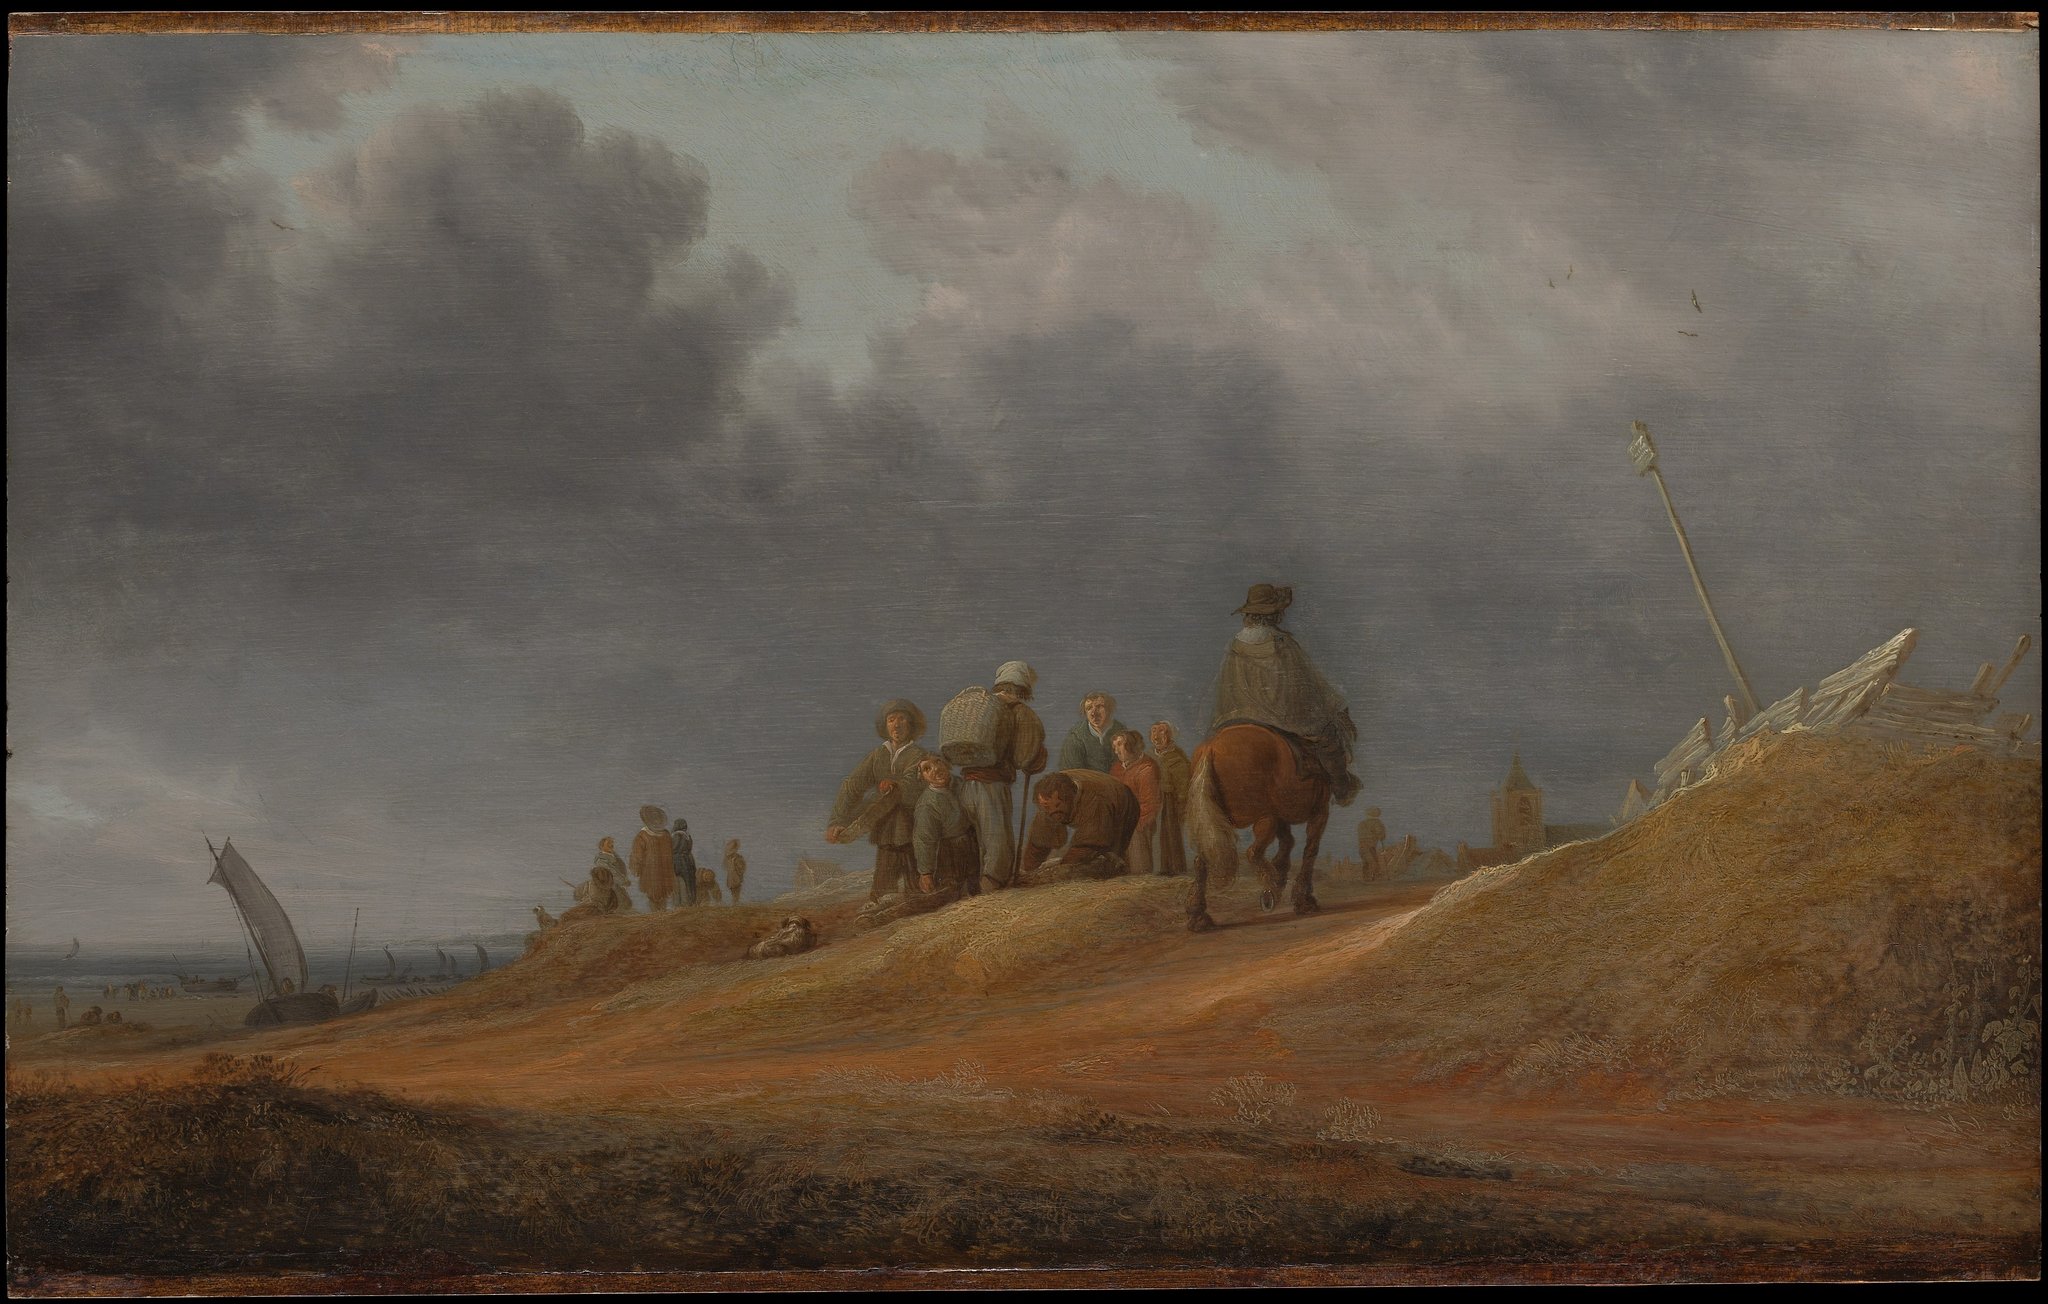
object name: painting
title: Market by the Seashore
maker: salomon van ruysdael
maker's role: artist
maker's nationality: dutch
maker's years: 1600-1670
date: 1637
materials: oil, wood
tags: men,horses,beaches,boats